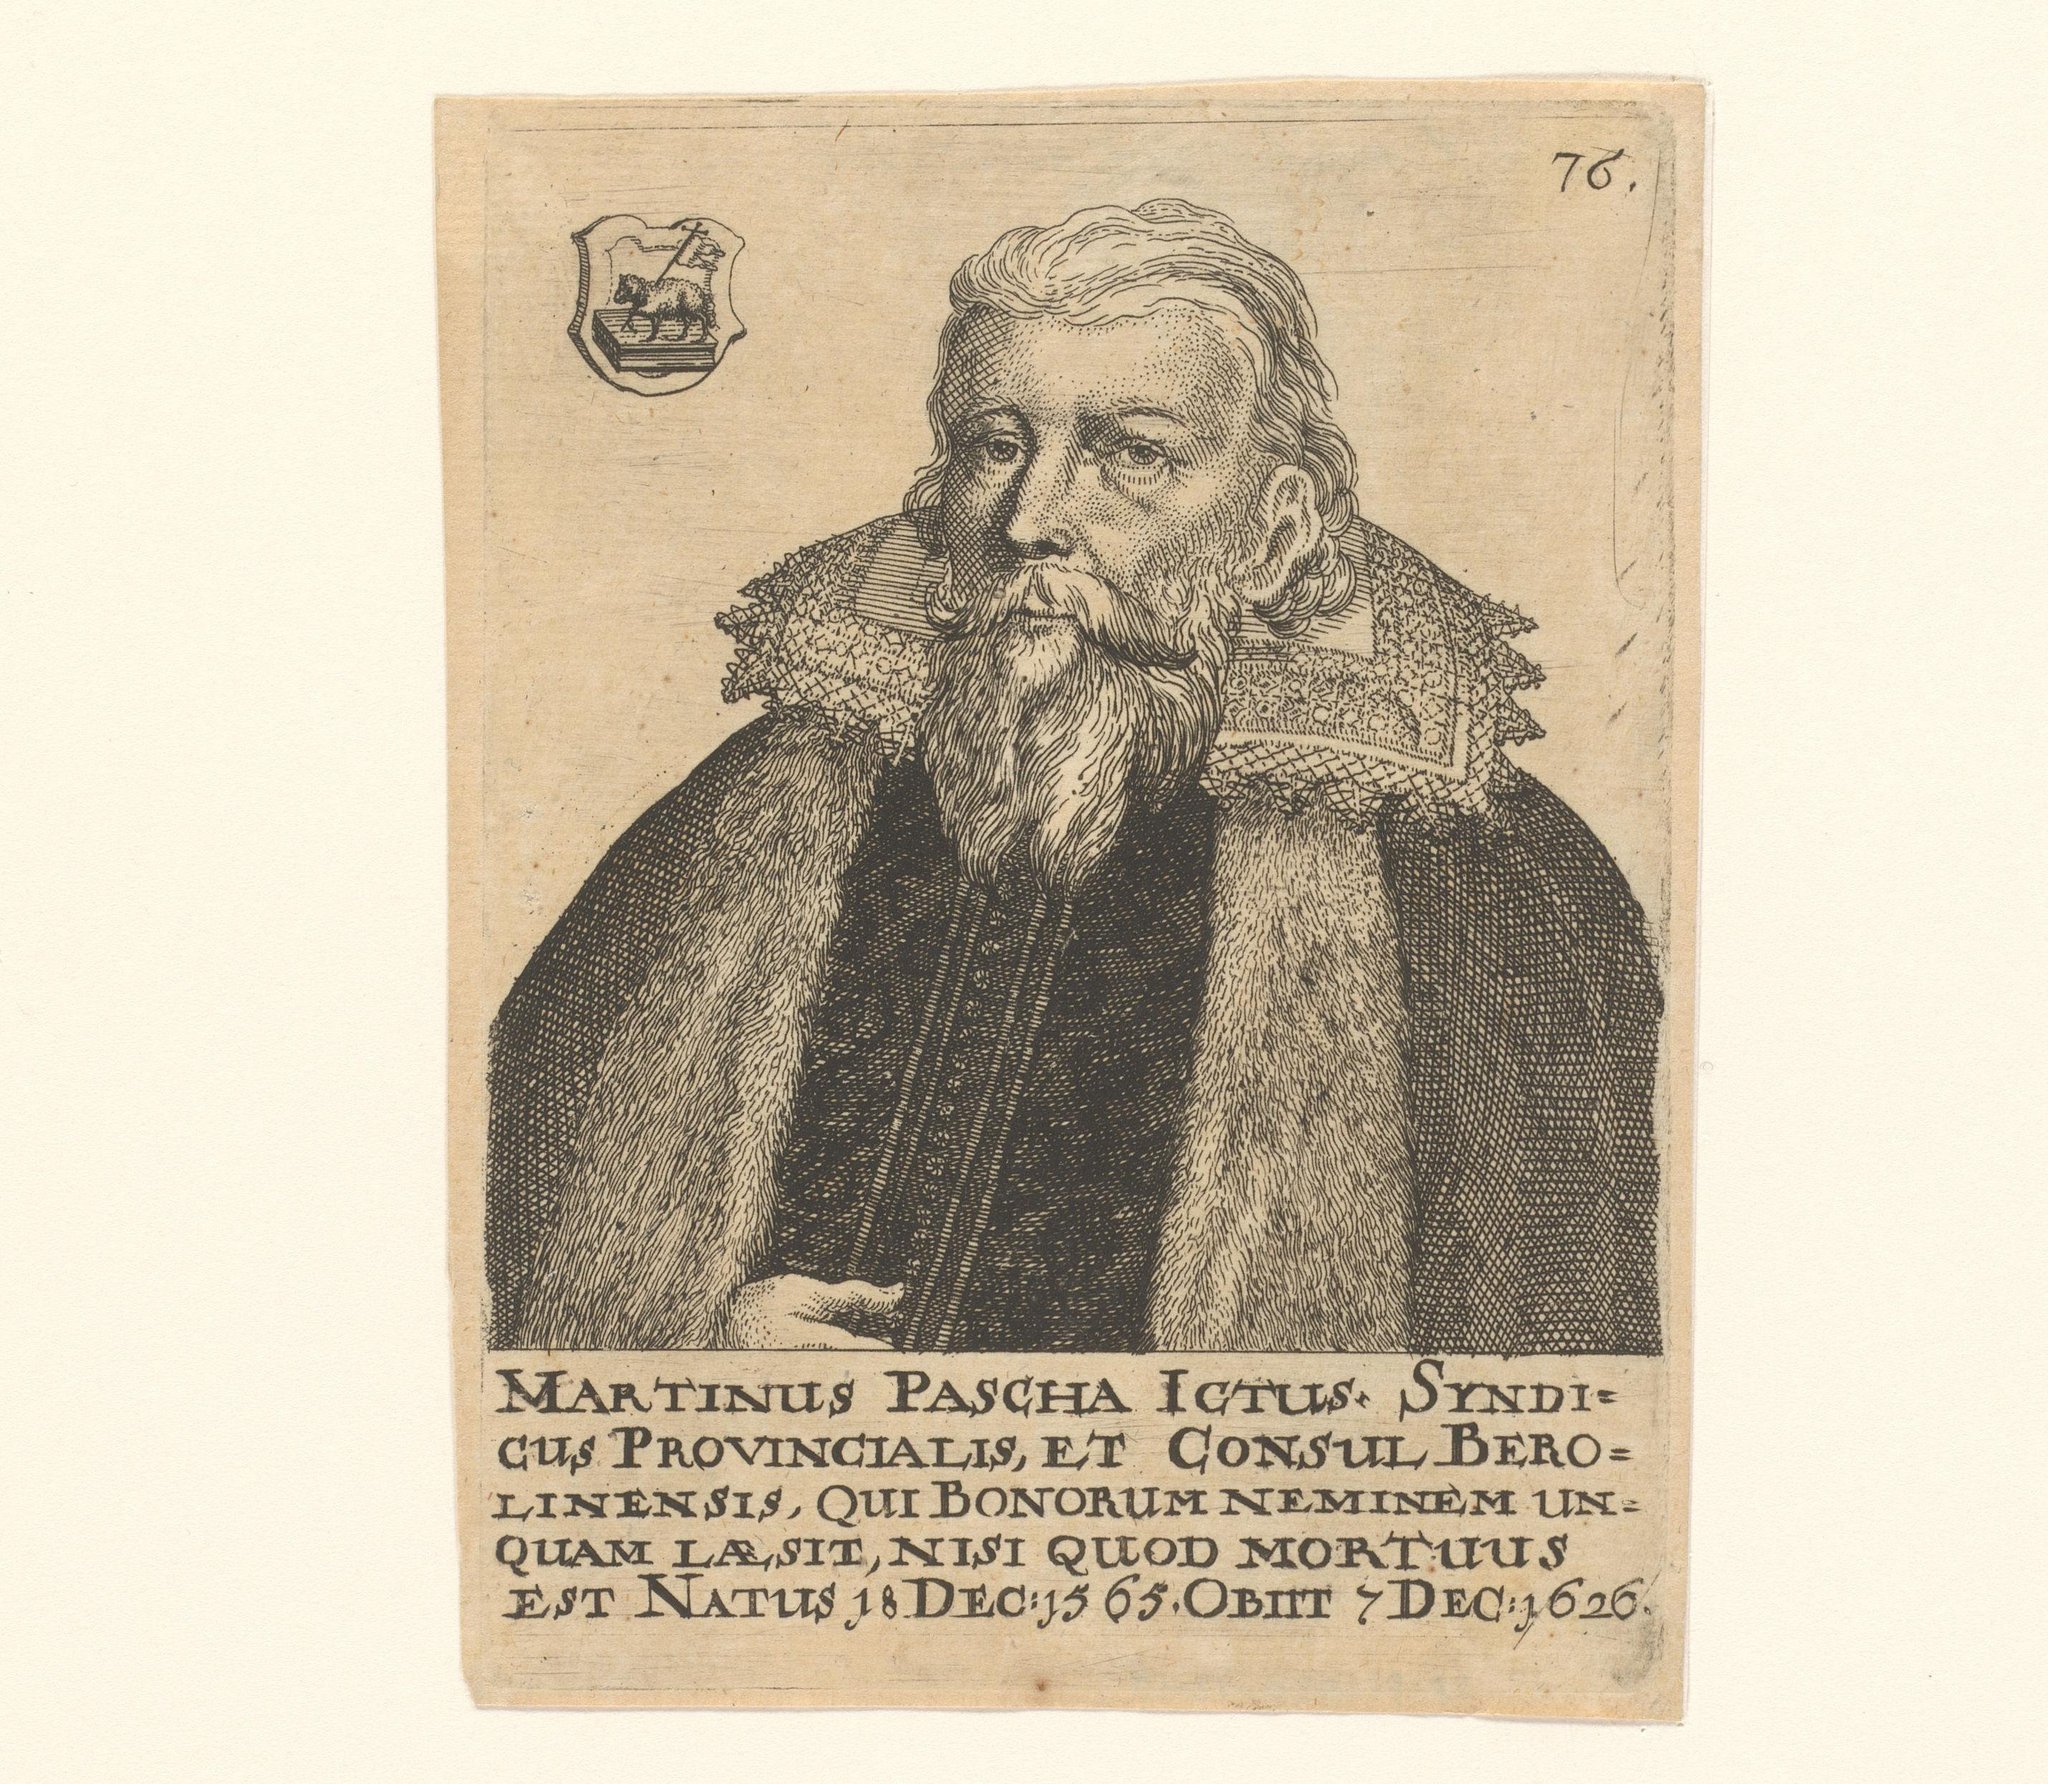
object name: print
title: Portret van Martin Pasche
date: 1671-1751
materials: paper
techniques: engraving, etching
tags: berlin, mayor, burgomaster, historical persons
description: De prent is uitgegeven als onderdeel van een serie. Later is de prent mogelijk ook als boekillustratie gebruikt in: Küster, Georg Gottfried. Martin Friedrich Seidels Bilder-Sammlung in welcher hundert, gröstentheils in der Mark Brandenburg (…). Berlijn: Buchladen bey der Real-Schule, 1751. Het is onduidelijk tot welke uitgave de huidige prent behoort.